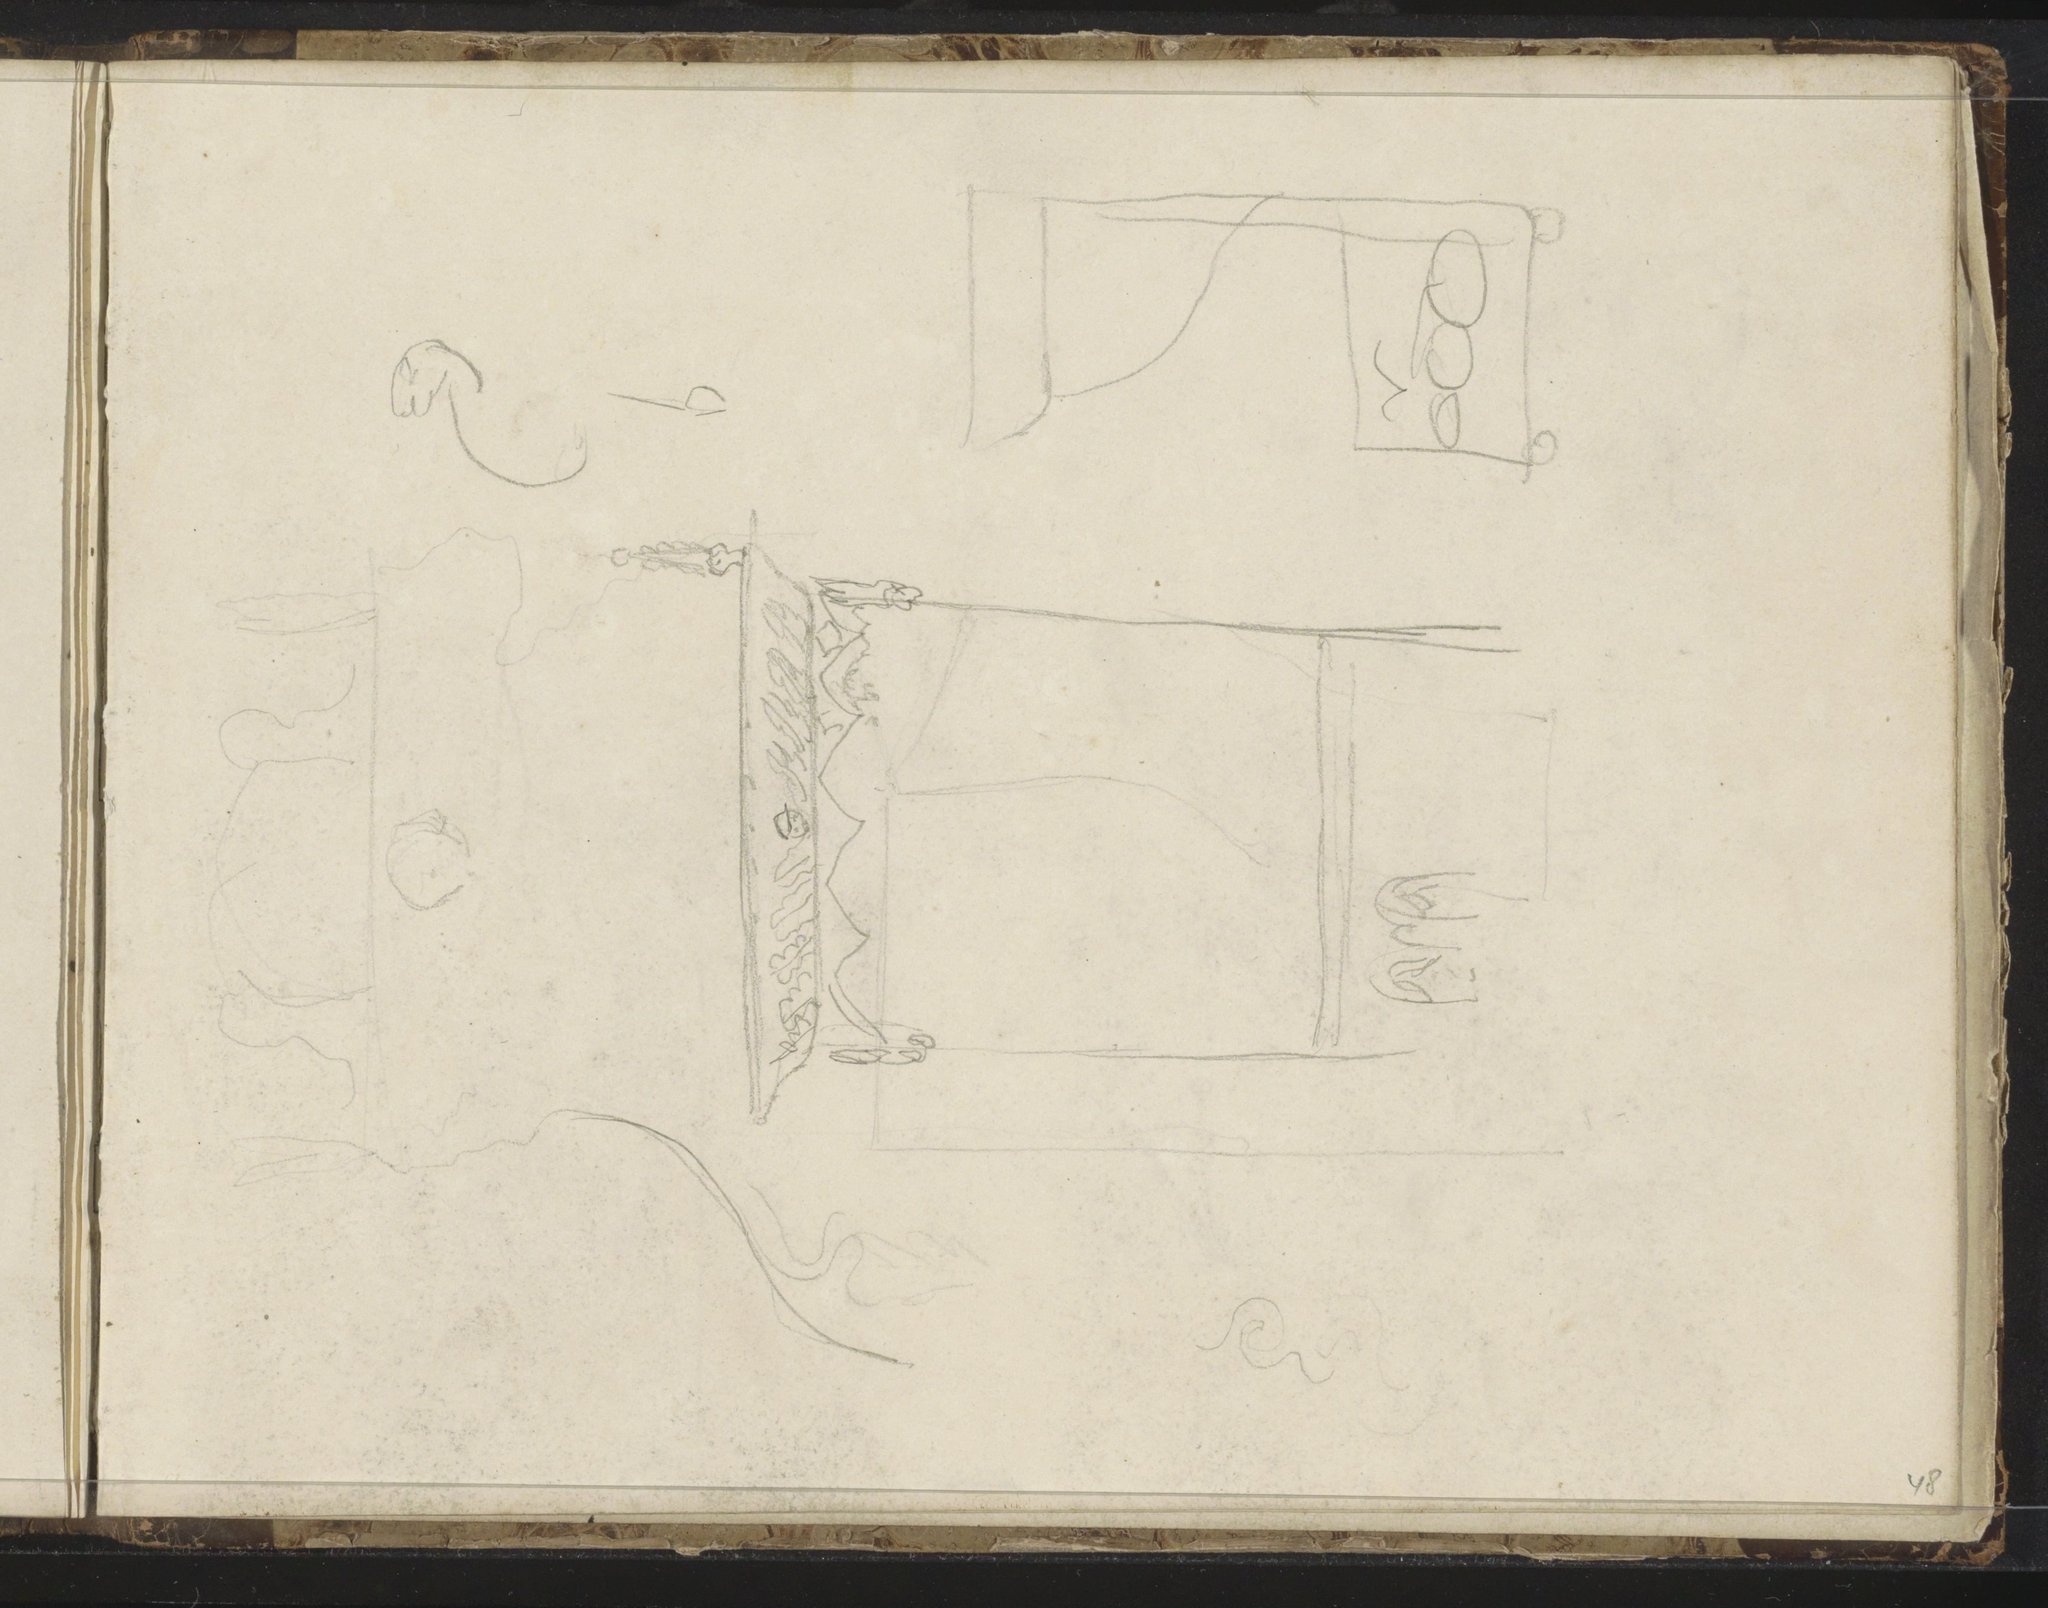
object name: sketchbook leaf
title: Meubilair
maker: willem hendrik schmidt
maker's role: draughtsman, painter, print maker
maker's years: 1809-1849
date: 1819-1849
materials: paper, pencil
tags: furniture and household effects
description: Blad 48 recto uit een schetsboek met 52 bladen.